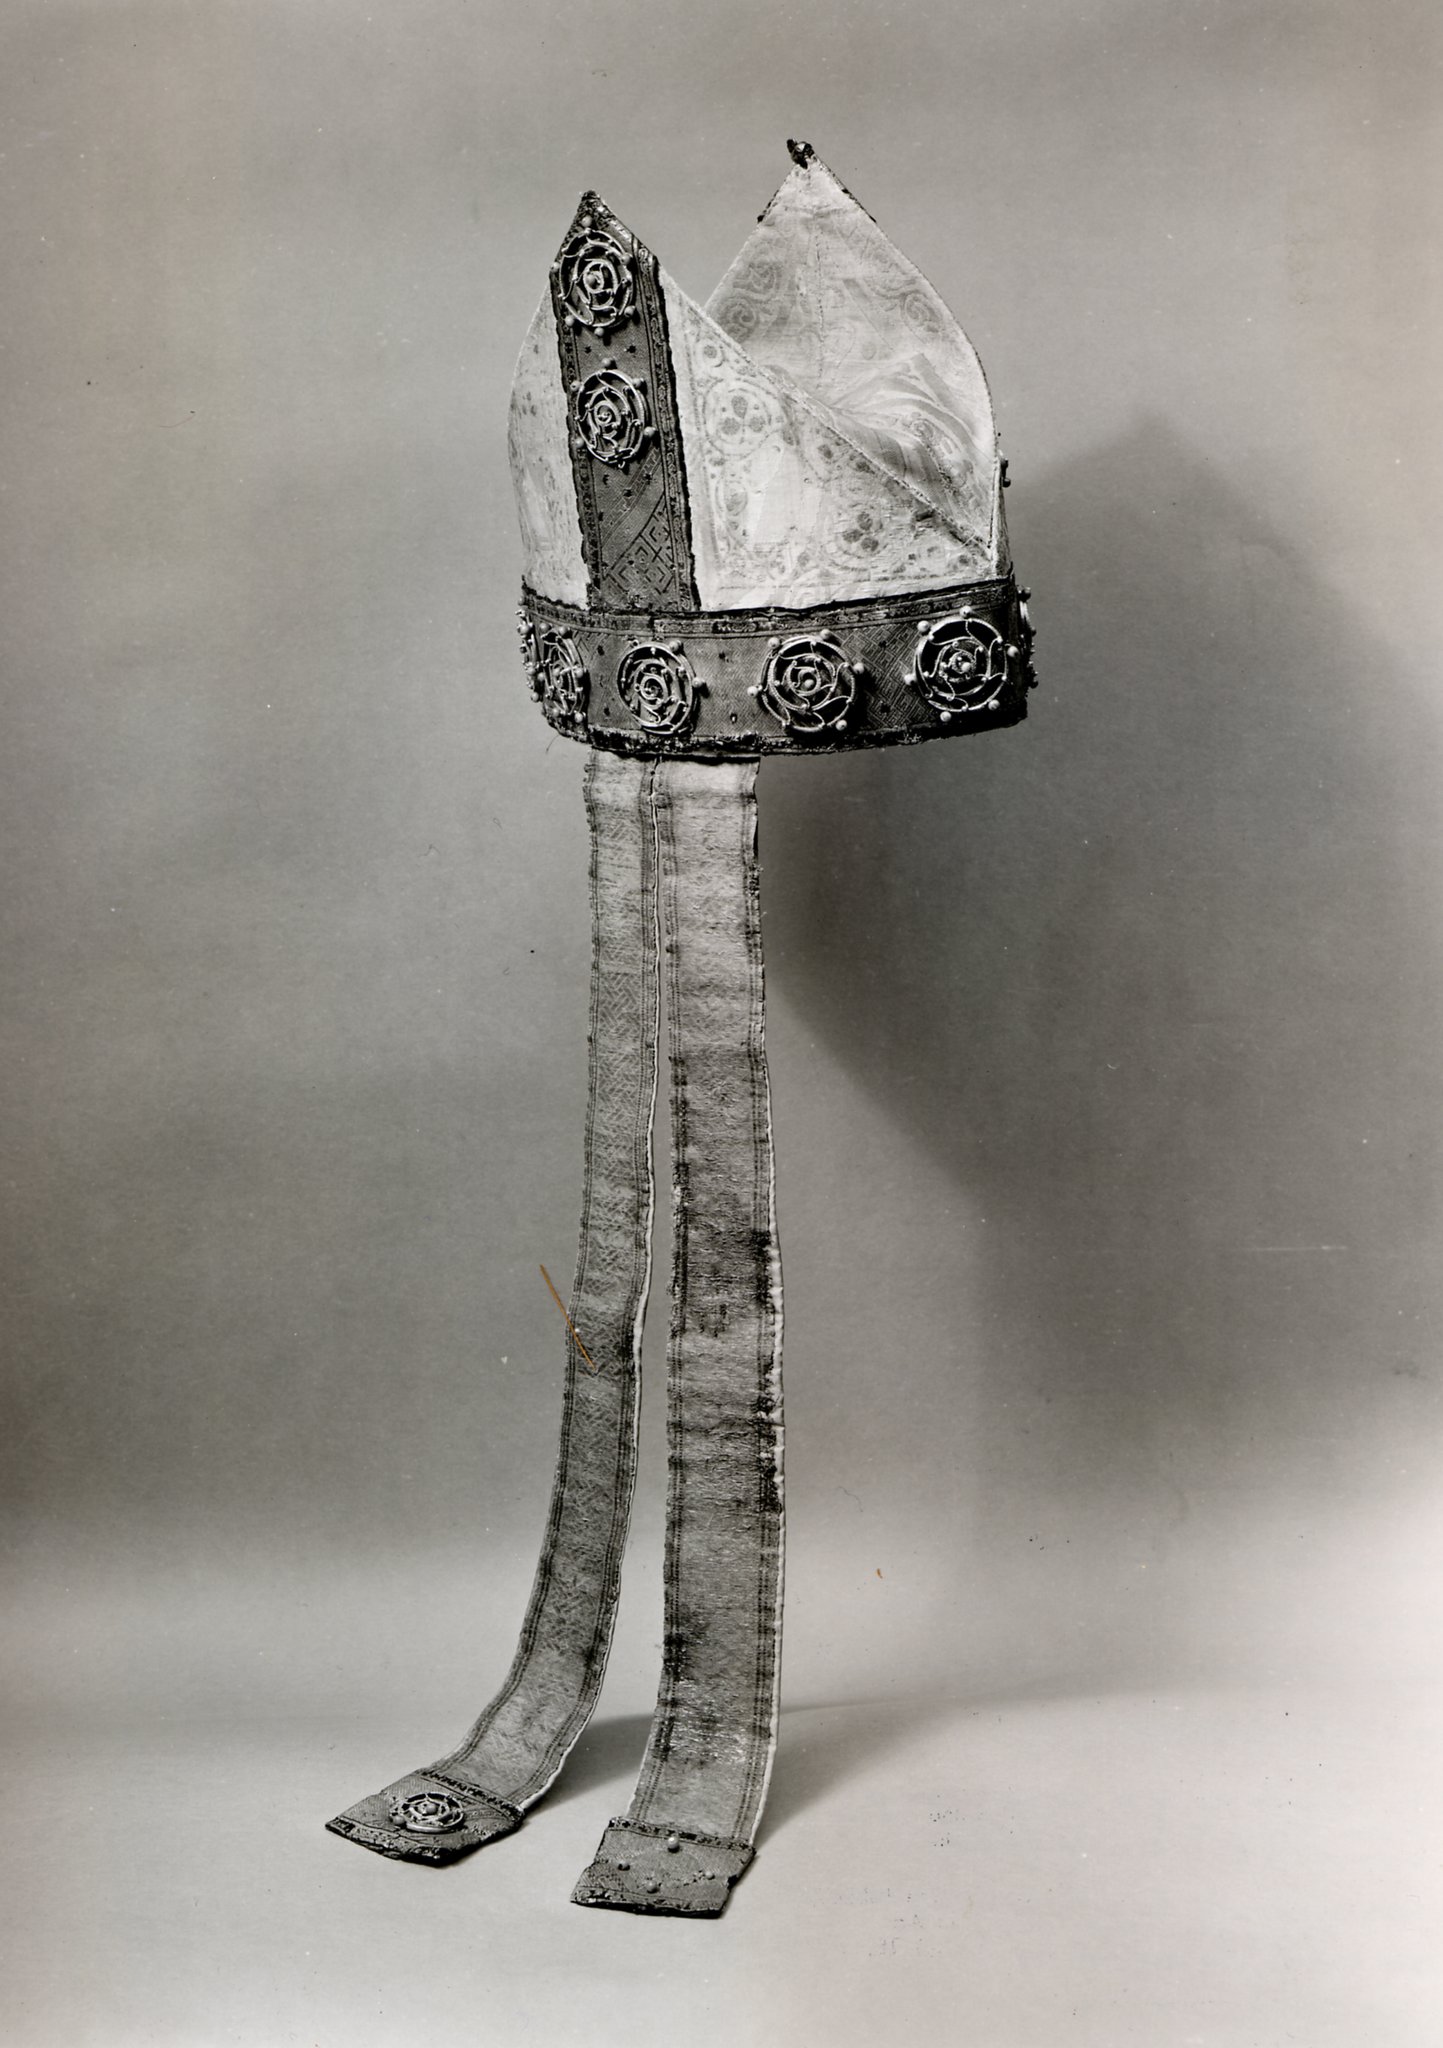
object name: mitre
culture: austrian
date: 1201-1300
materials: coral, metal thread, silk, silver gilt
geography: austria